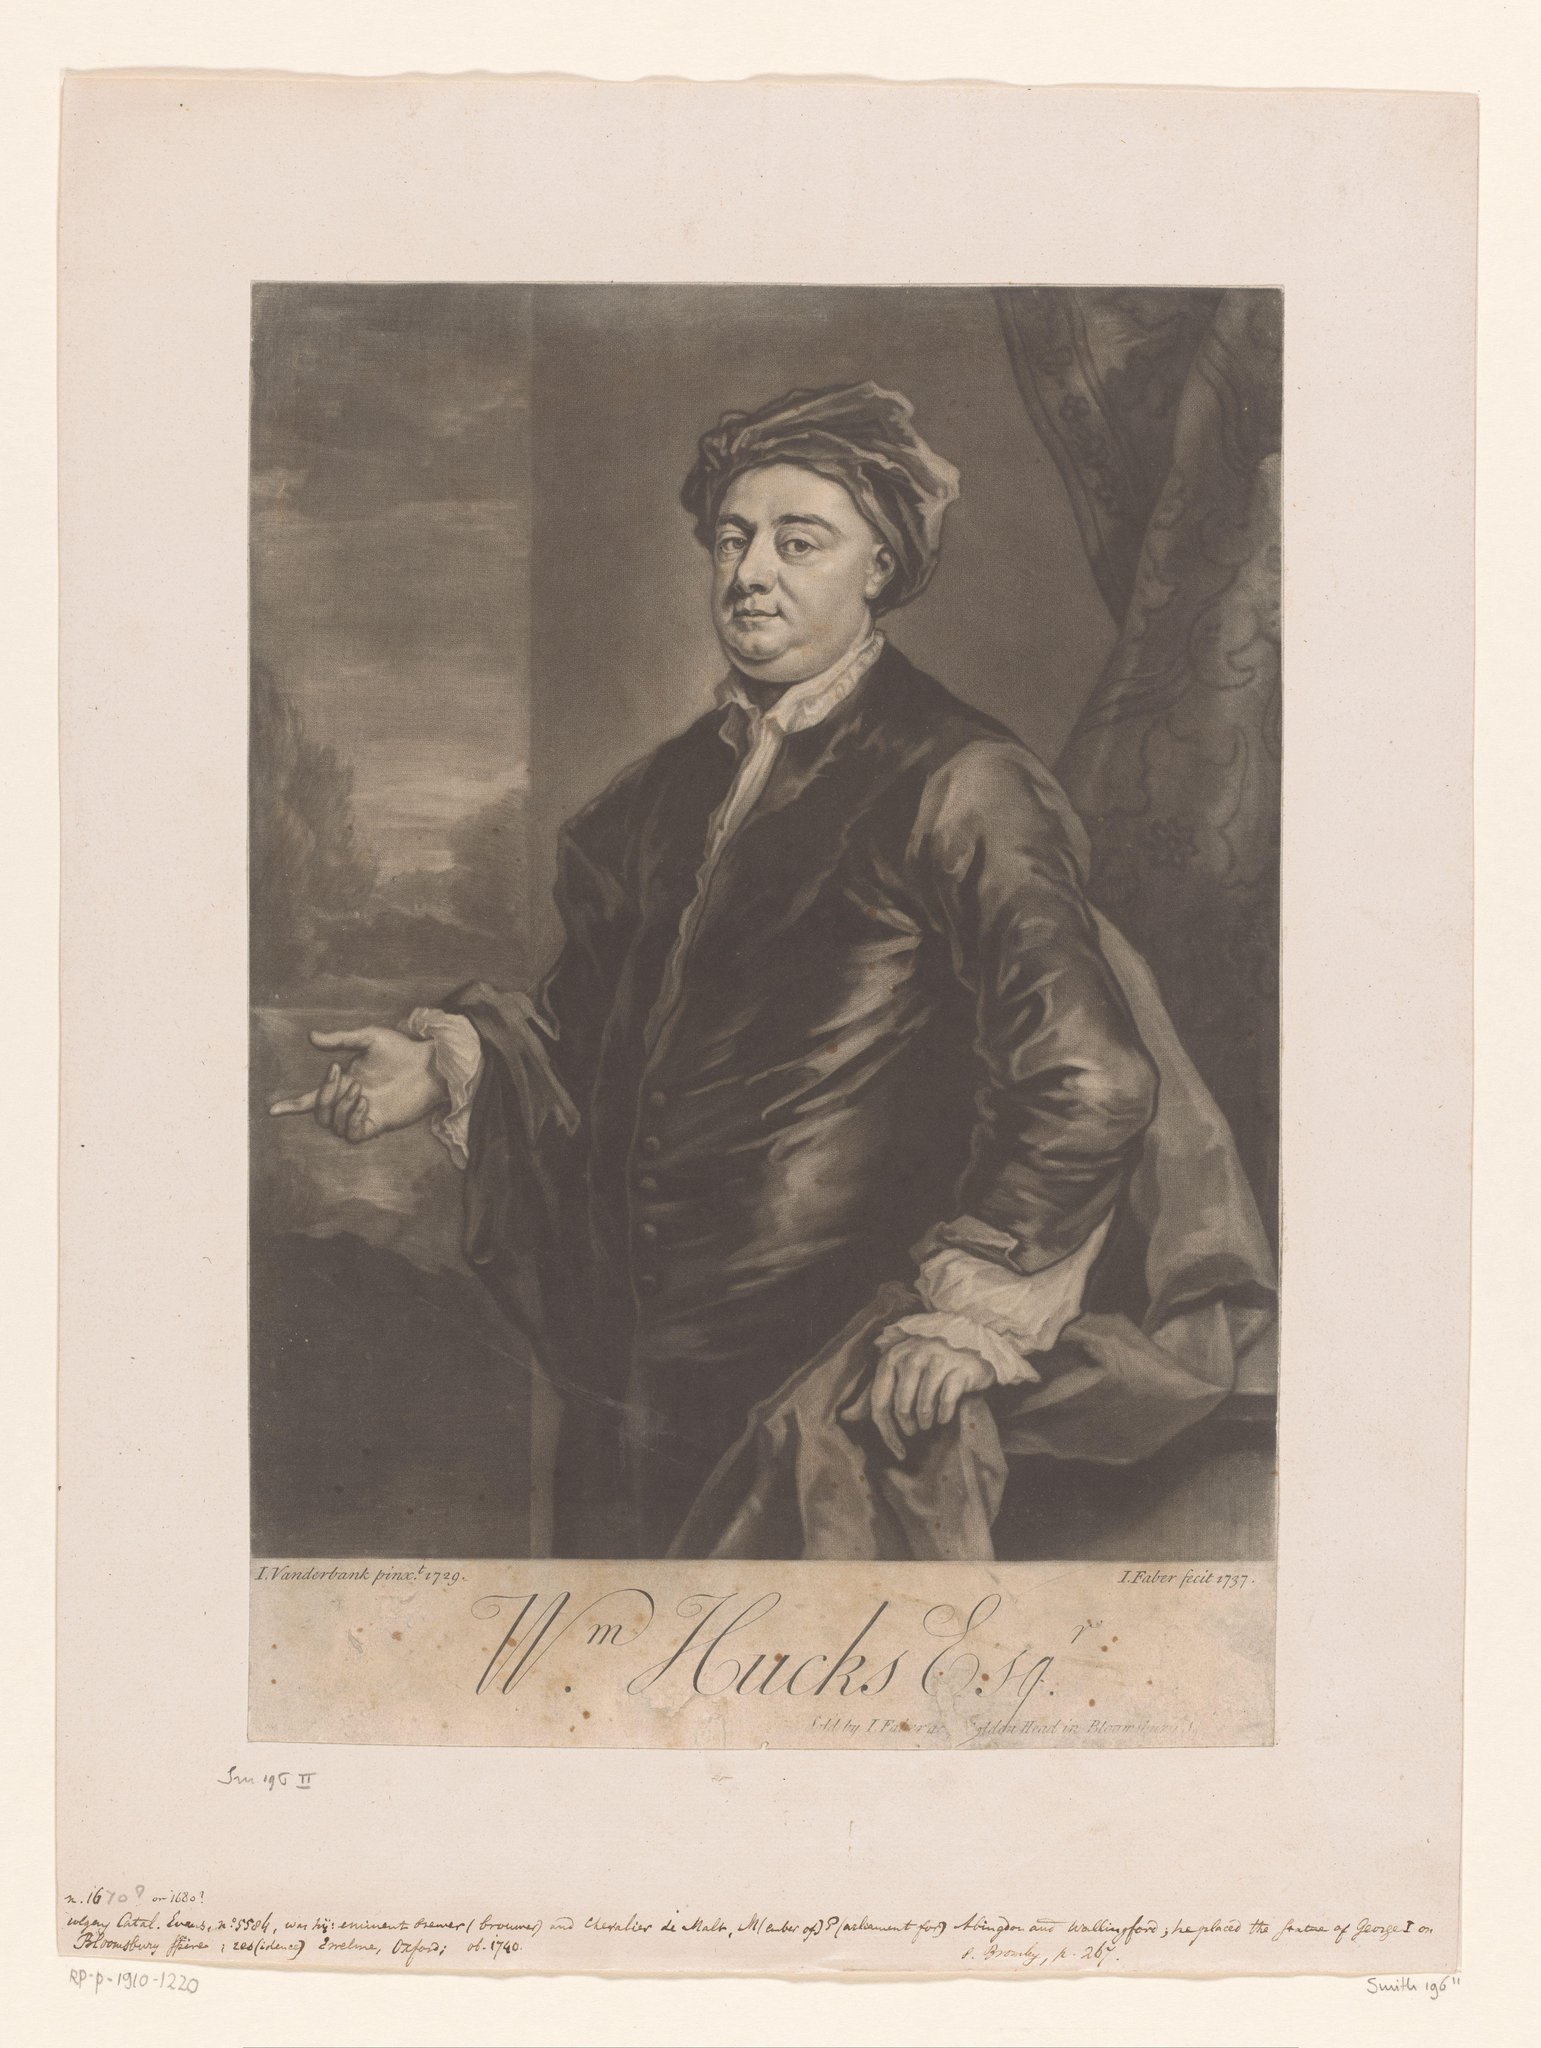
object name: print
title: Portret van William Hucks Esqr.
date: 1729-1737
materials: paper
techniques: etching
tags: politician, brewer, historical persons, politician, e.g. party leader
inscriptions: collector's mark: Lugt 2228